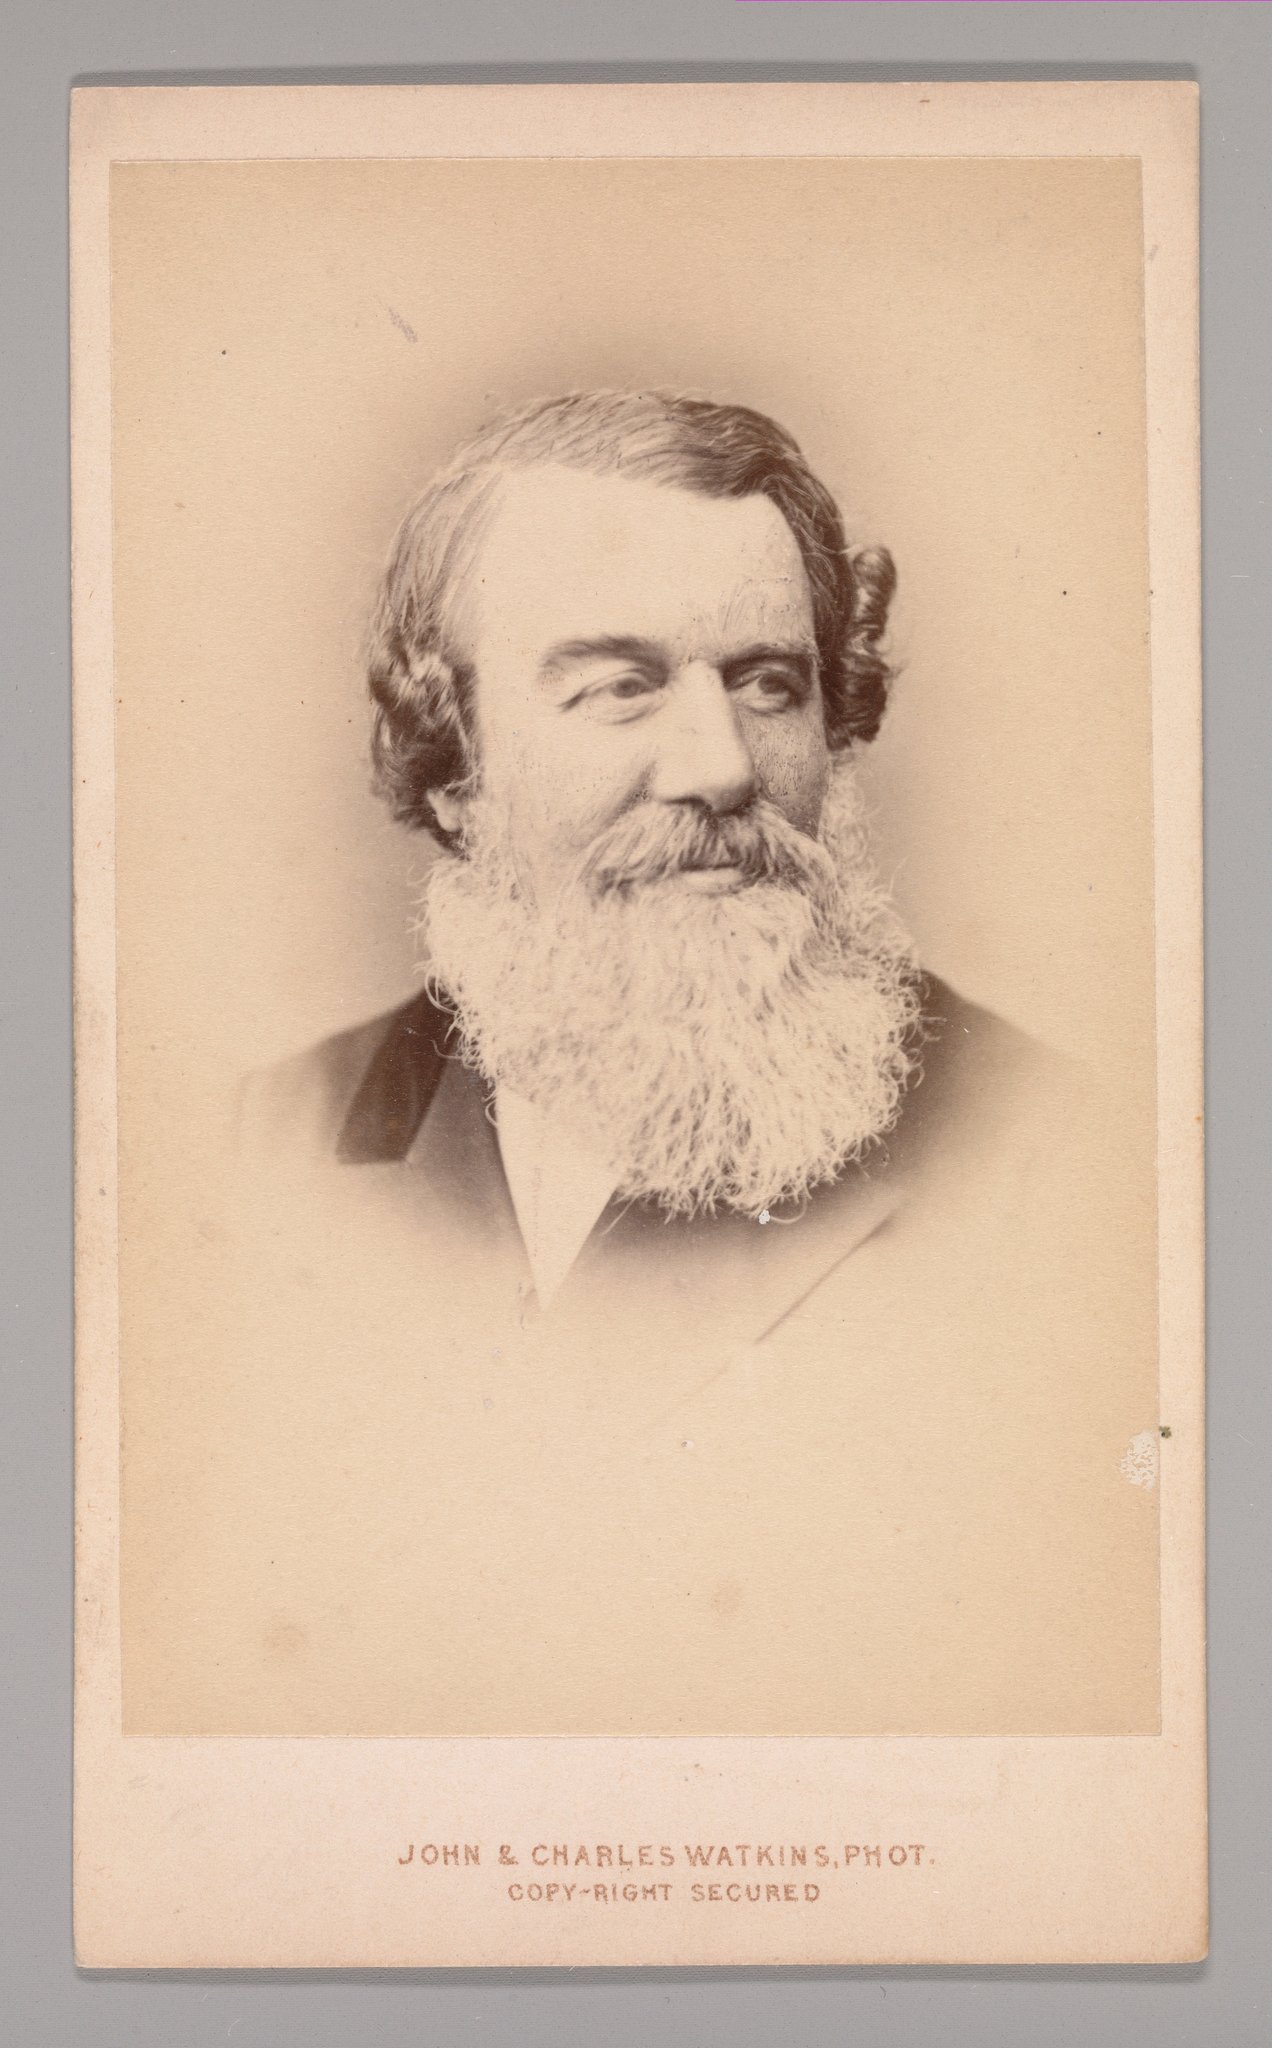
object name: carte de visite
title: [Unknown Subject]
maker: john and charles watkins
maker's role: photography studio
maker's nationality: british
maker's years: 1840-1875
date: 1860-1869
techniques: albumen silver print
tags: men,portraits